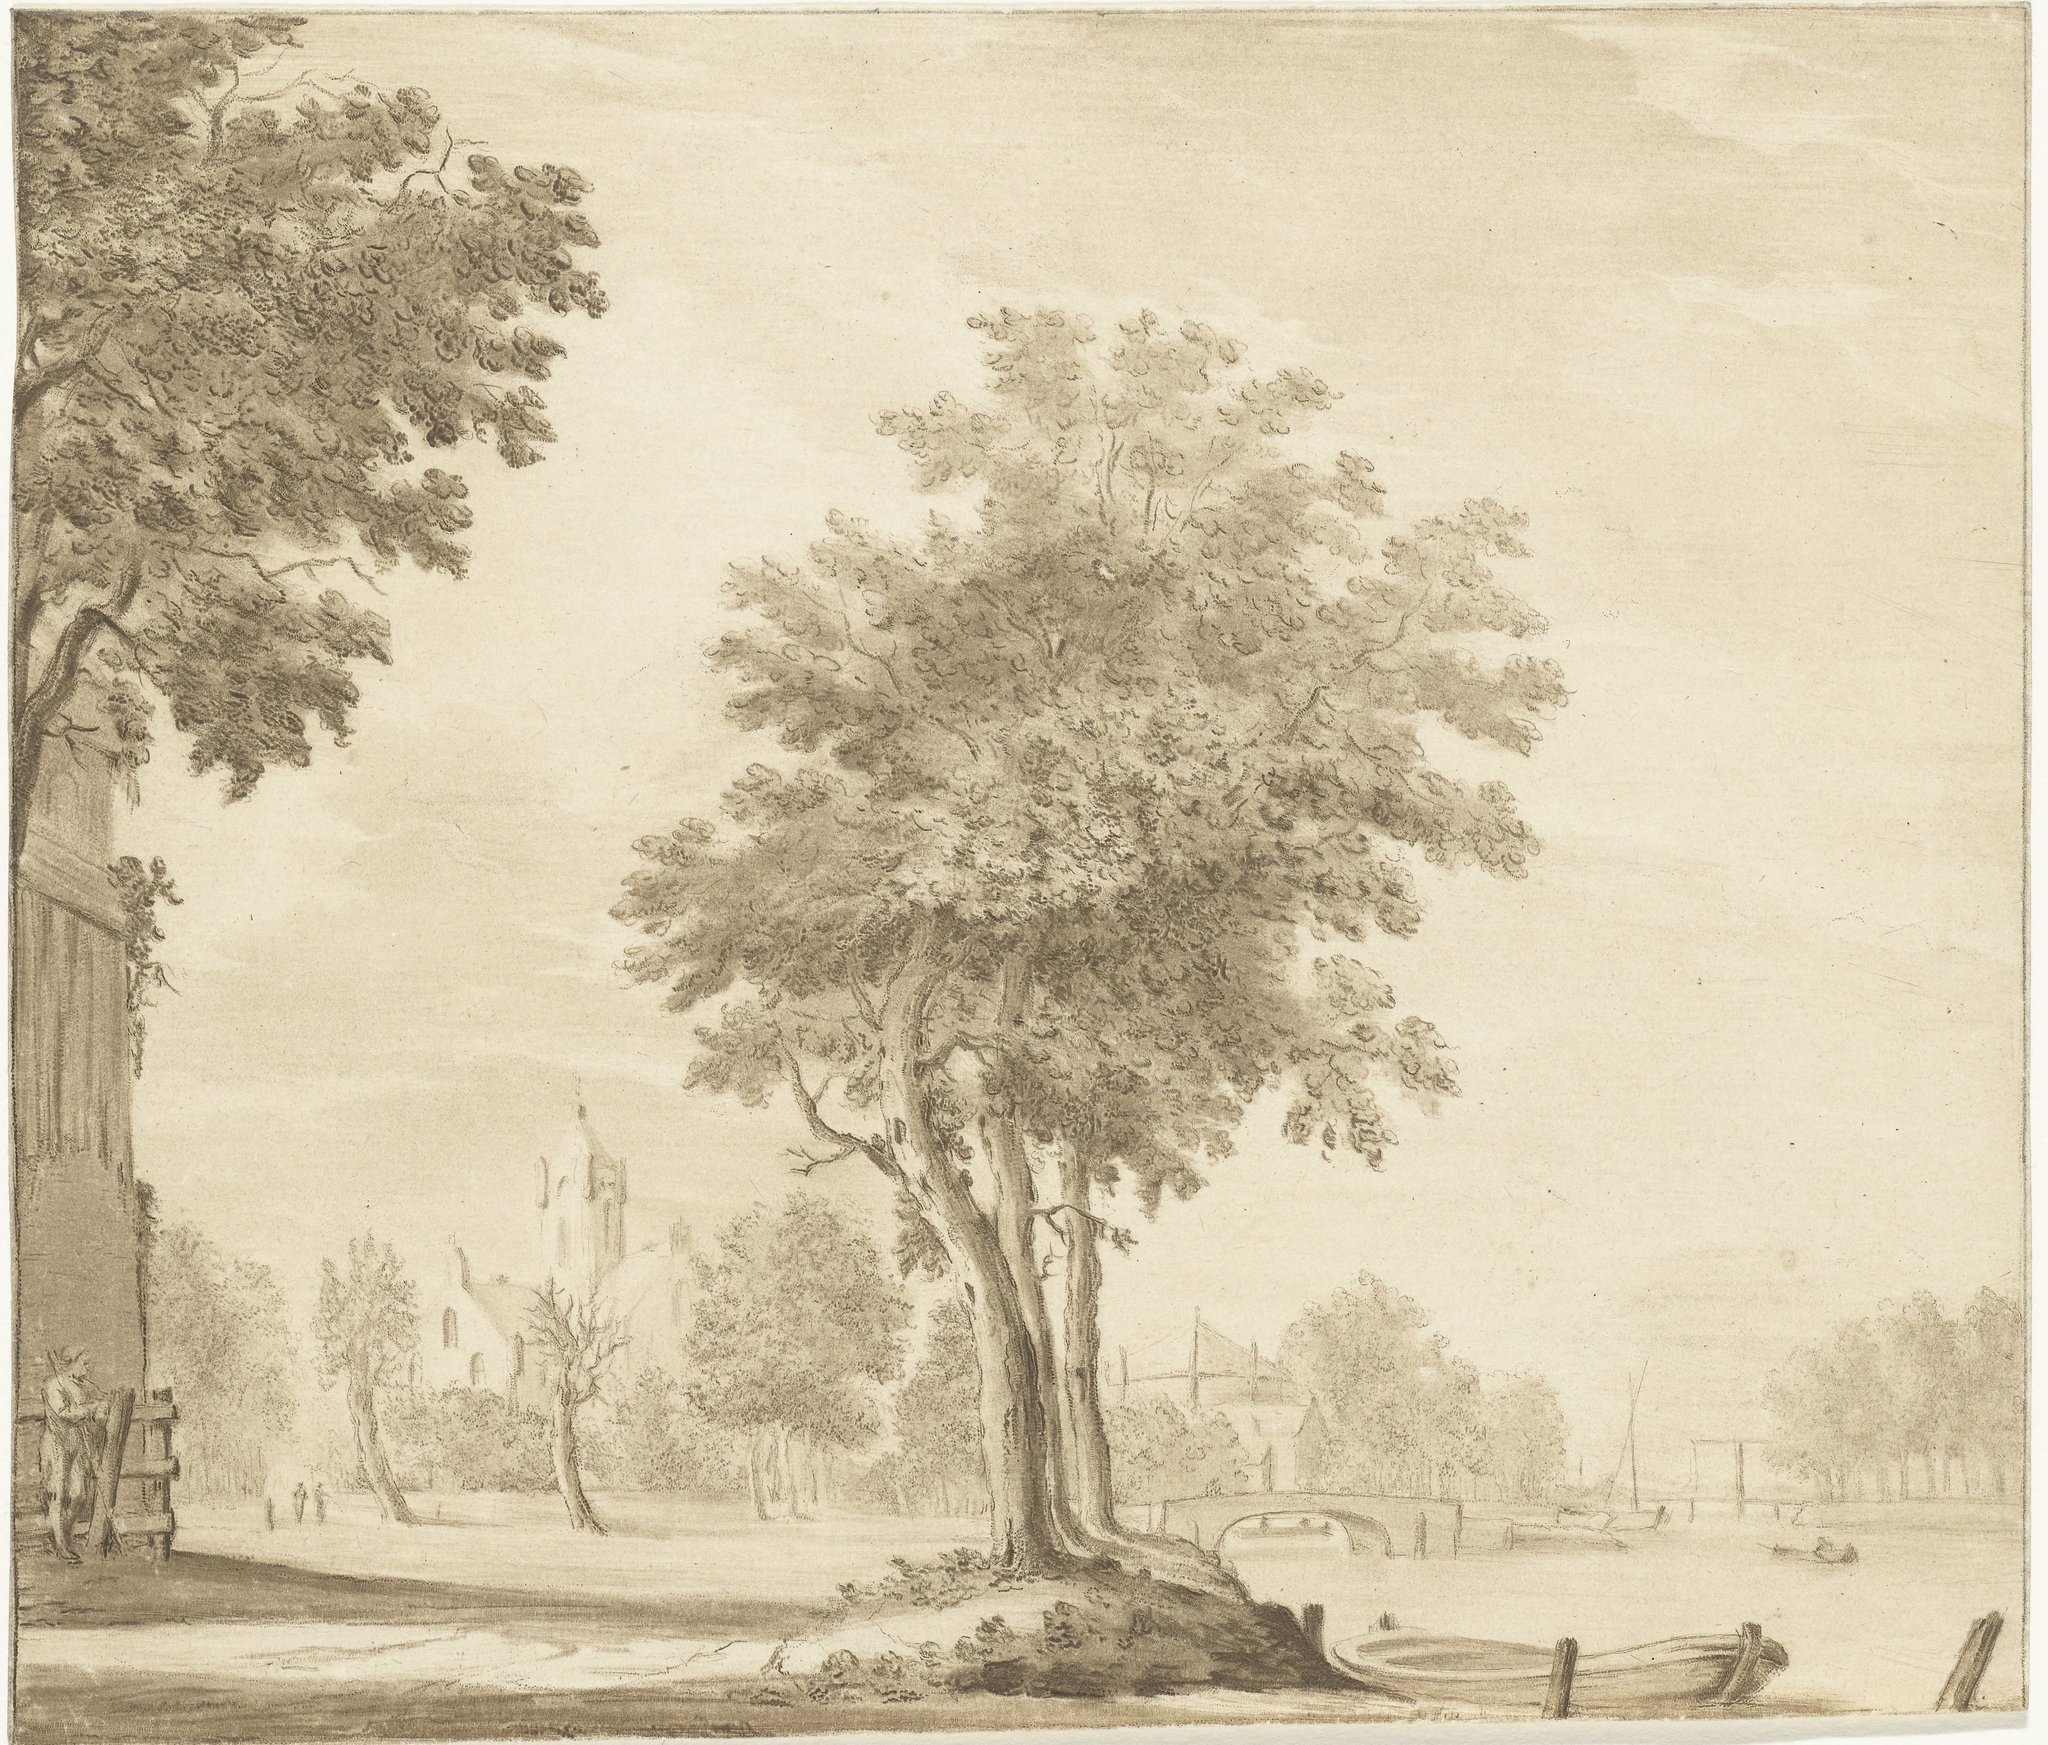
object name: print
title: Gezicht op een dorp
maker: jurriaan cootwijck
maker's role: print maker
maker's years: 1714-1798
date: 1724-1798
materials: paper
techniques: print drawing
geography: amsterdam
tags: trees, village (+ city(-scape) with figures, staffage), bridge in village across river, canal, etc.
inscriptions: collector's mark: Lugt 2228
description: Gezicht op een dorp. Het dorp ligt aan een rivier. Op de achtergrond de kerk en een brug over de rivier. Op de voorgrond drie hoge bomen.